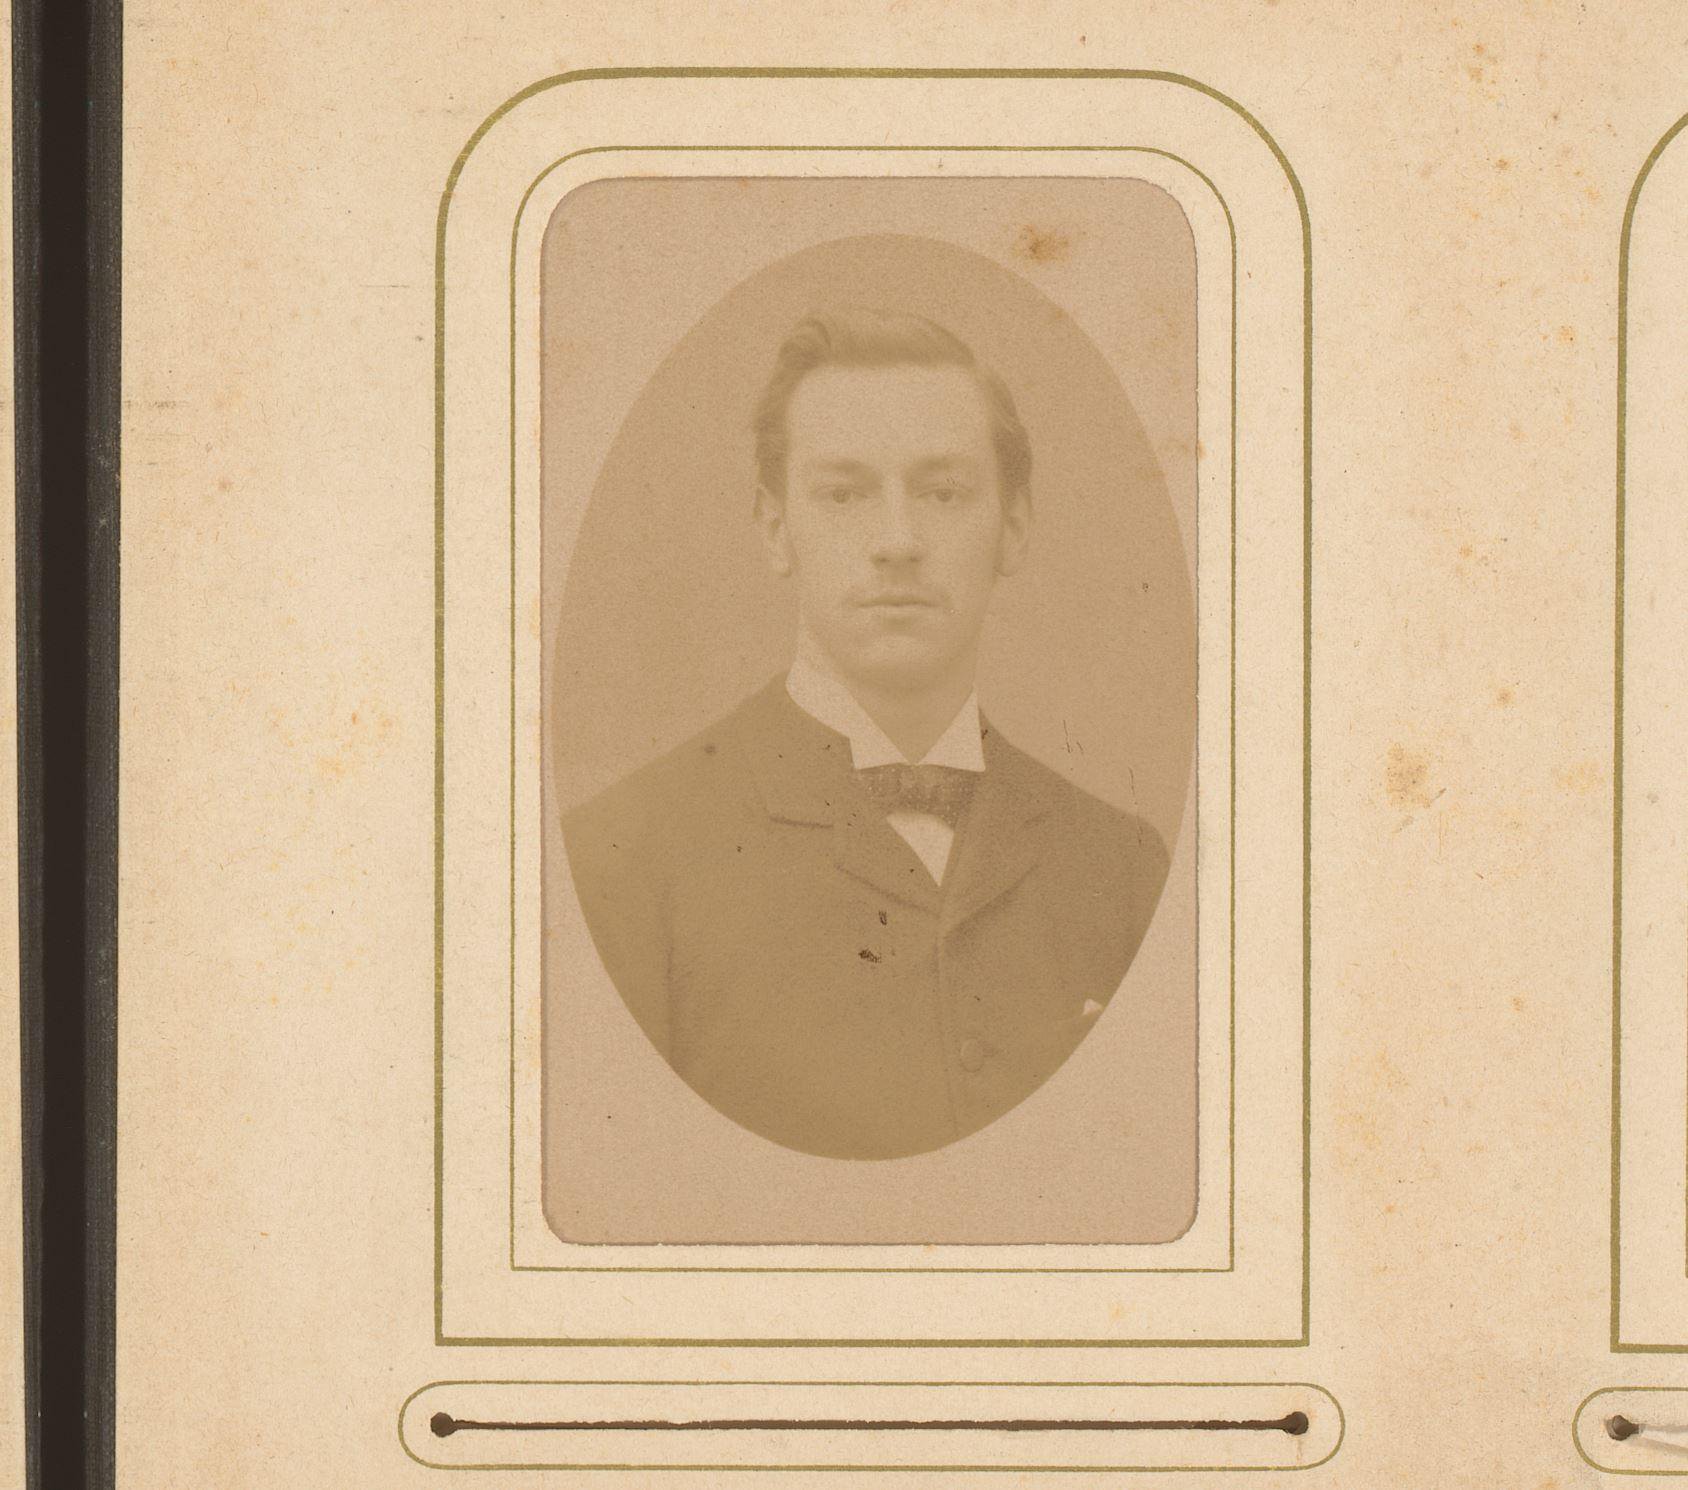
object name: album leaf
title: Portret van een man met vlinderstrik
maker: lodewijk hendrikus serré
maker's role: fotograaf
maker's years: 1847-1897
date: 1877-1897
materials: cardboard, photographic support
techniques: albumen print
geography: utrecht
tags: historical persons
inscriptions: inscription: ‘L. H. SERRÉ/ PHOTOGRAPHE/ NACHTEGAALSTRAAT, over het Park Tivoli/ Utrecht/ 's Hage, Tiel en Arnhem./ Voor nabestelling blijft de plaat bewaard.’